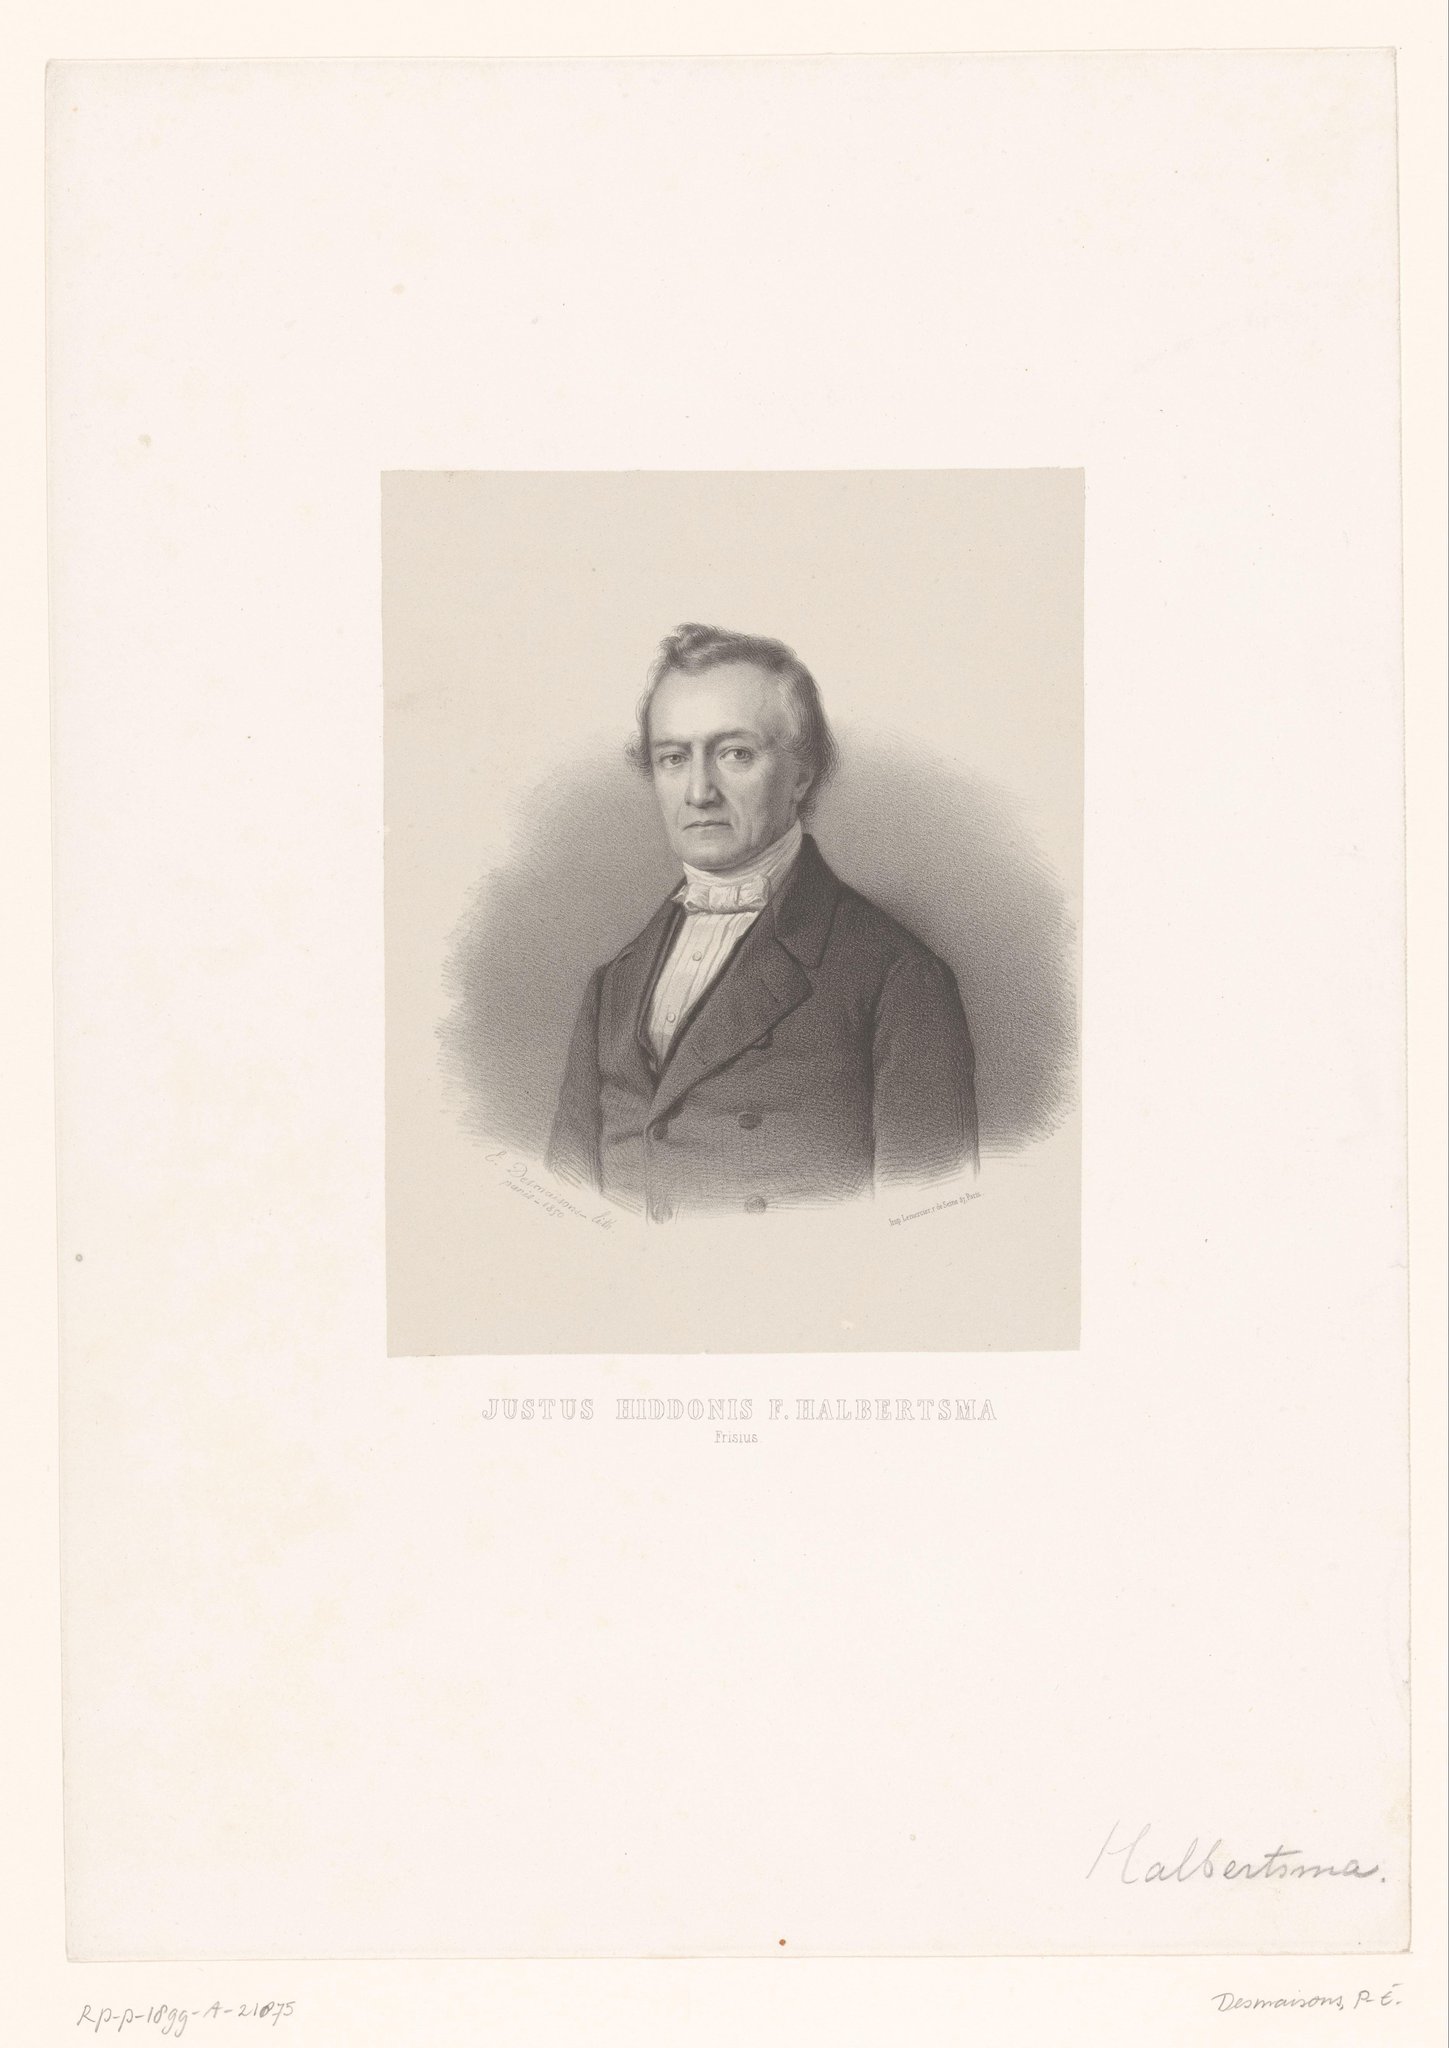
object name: print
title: Justus Hiddonis F. Halbertsma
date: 1850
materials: paper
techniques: lithograph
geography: paris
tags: deventer, historical persons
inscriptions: collector's mark: Lugt 2228a